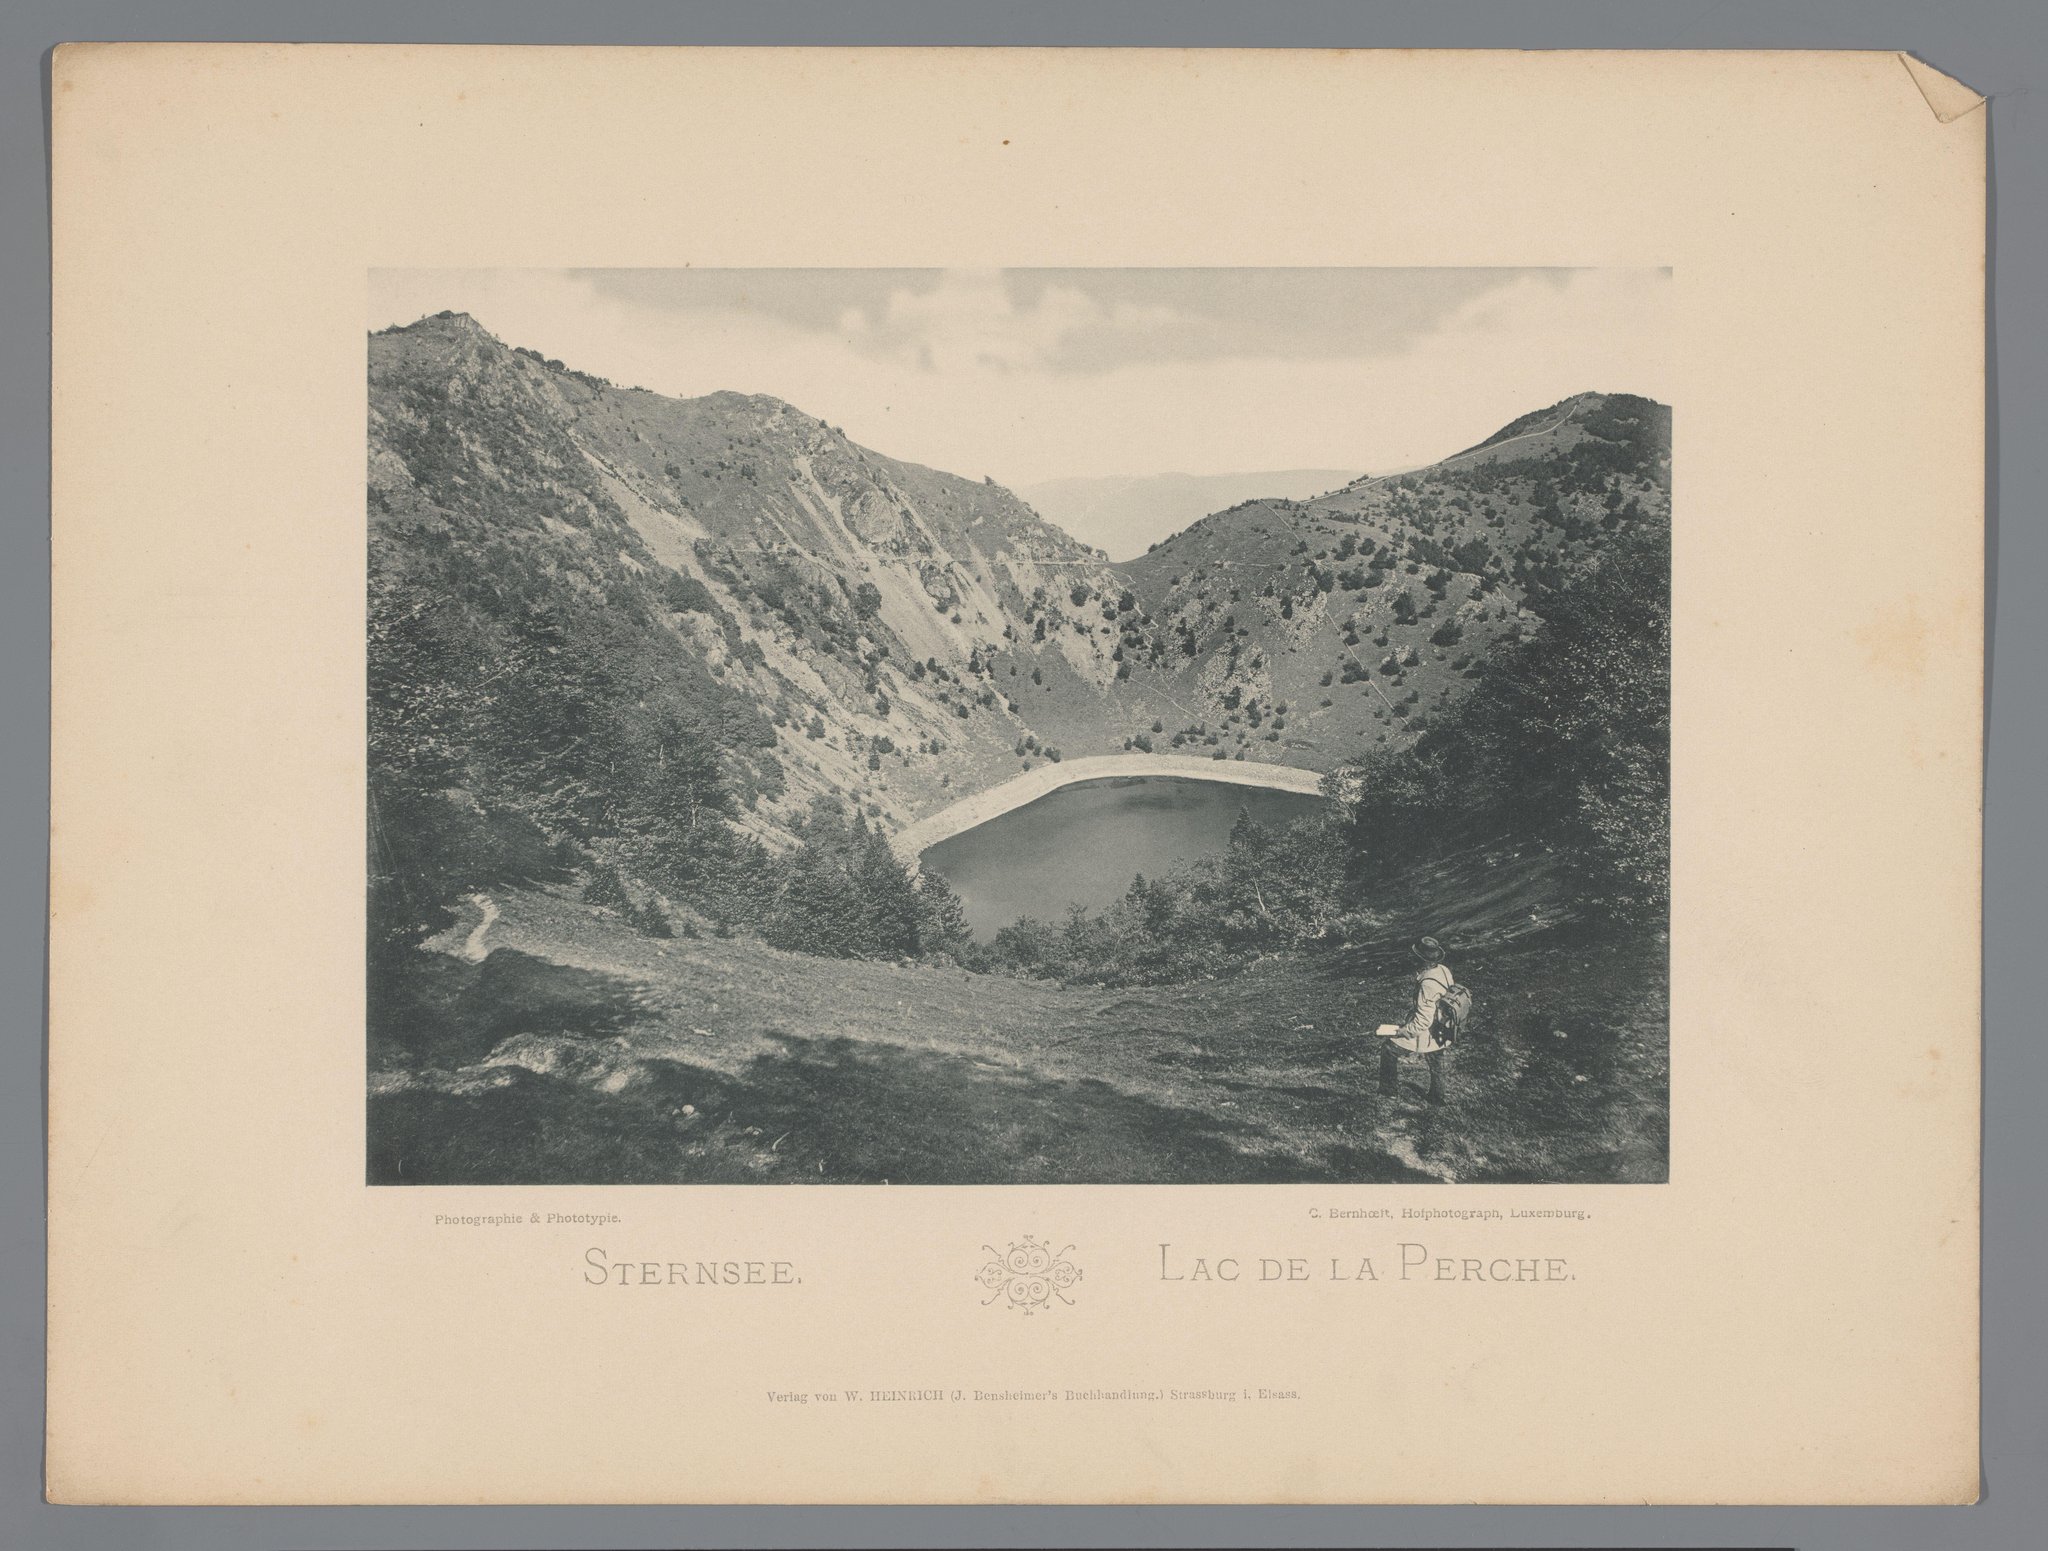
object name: page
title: Sternsee, Lac de la Perche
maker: charles bernhoeft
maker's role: publisher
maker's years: 1859-1933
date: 1889-1894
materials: paper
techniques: photograph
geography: rimbach-près-masevaux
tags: lake (+ landscape with figures, staffage)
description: Deze prent maakt deel uit van een omslag met 100 prenten.